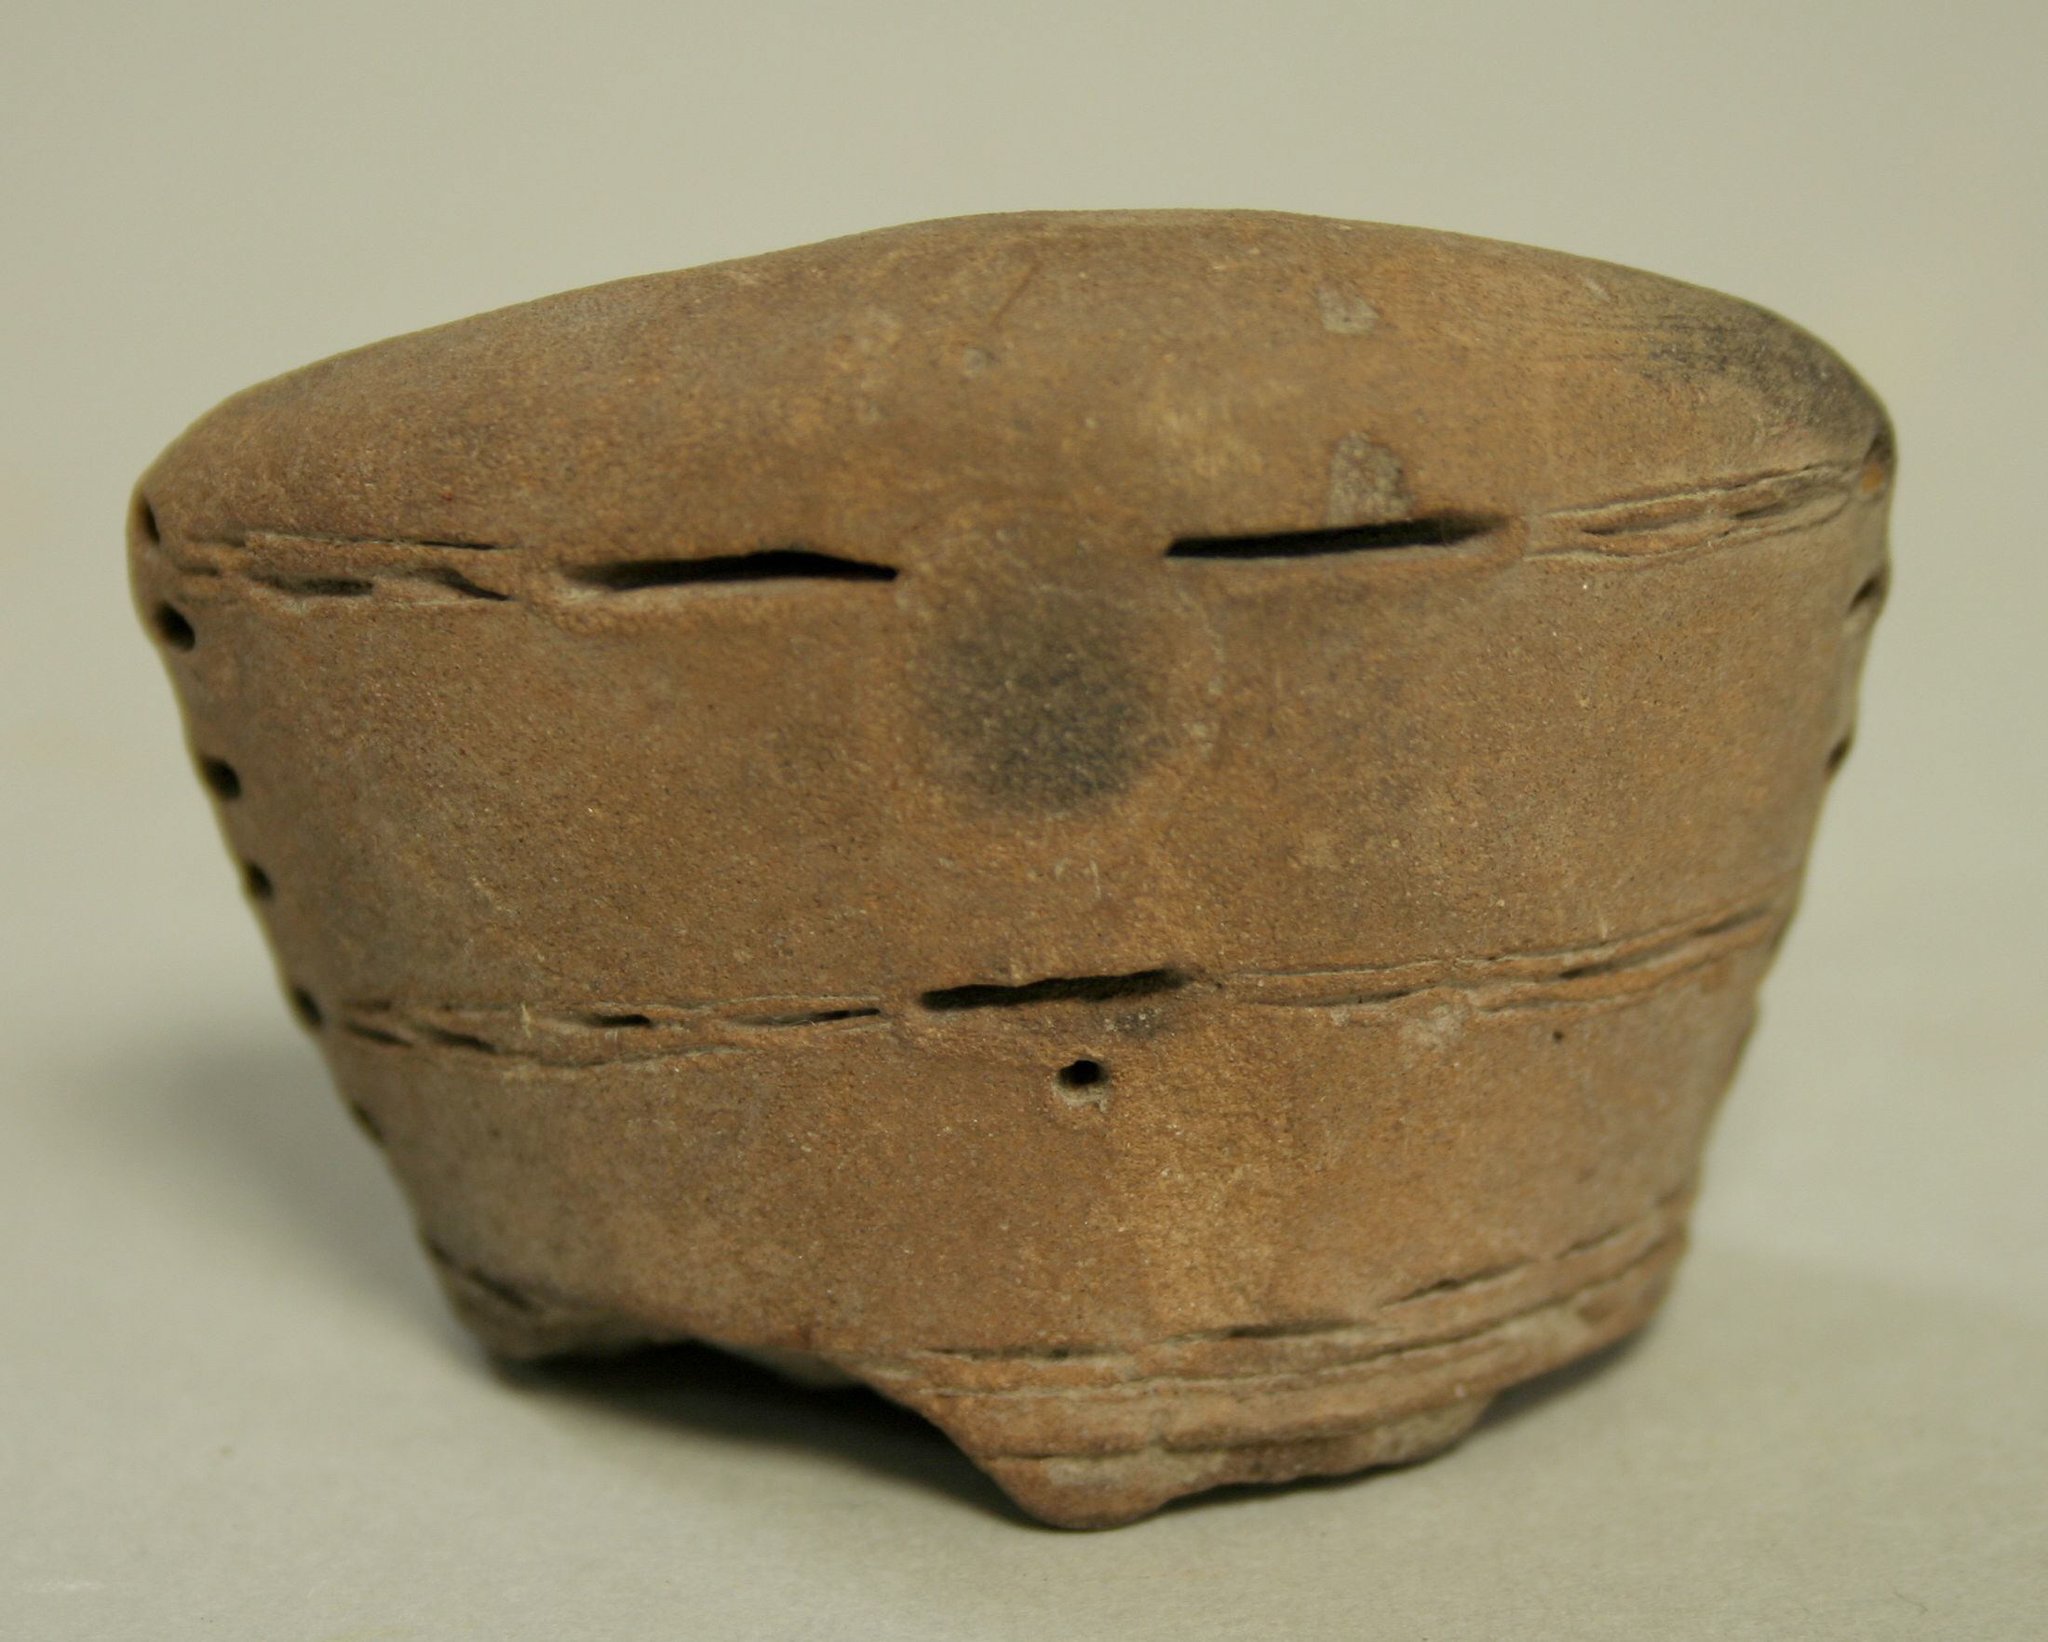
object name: head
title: Terracotta Head Fragment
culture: guangala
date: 500 BCE-600 CE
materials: ceramic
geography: ecuador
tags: heads